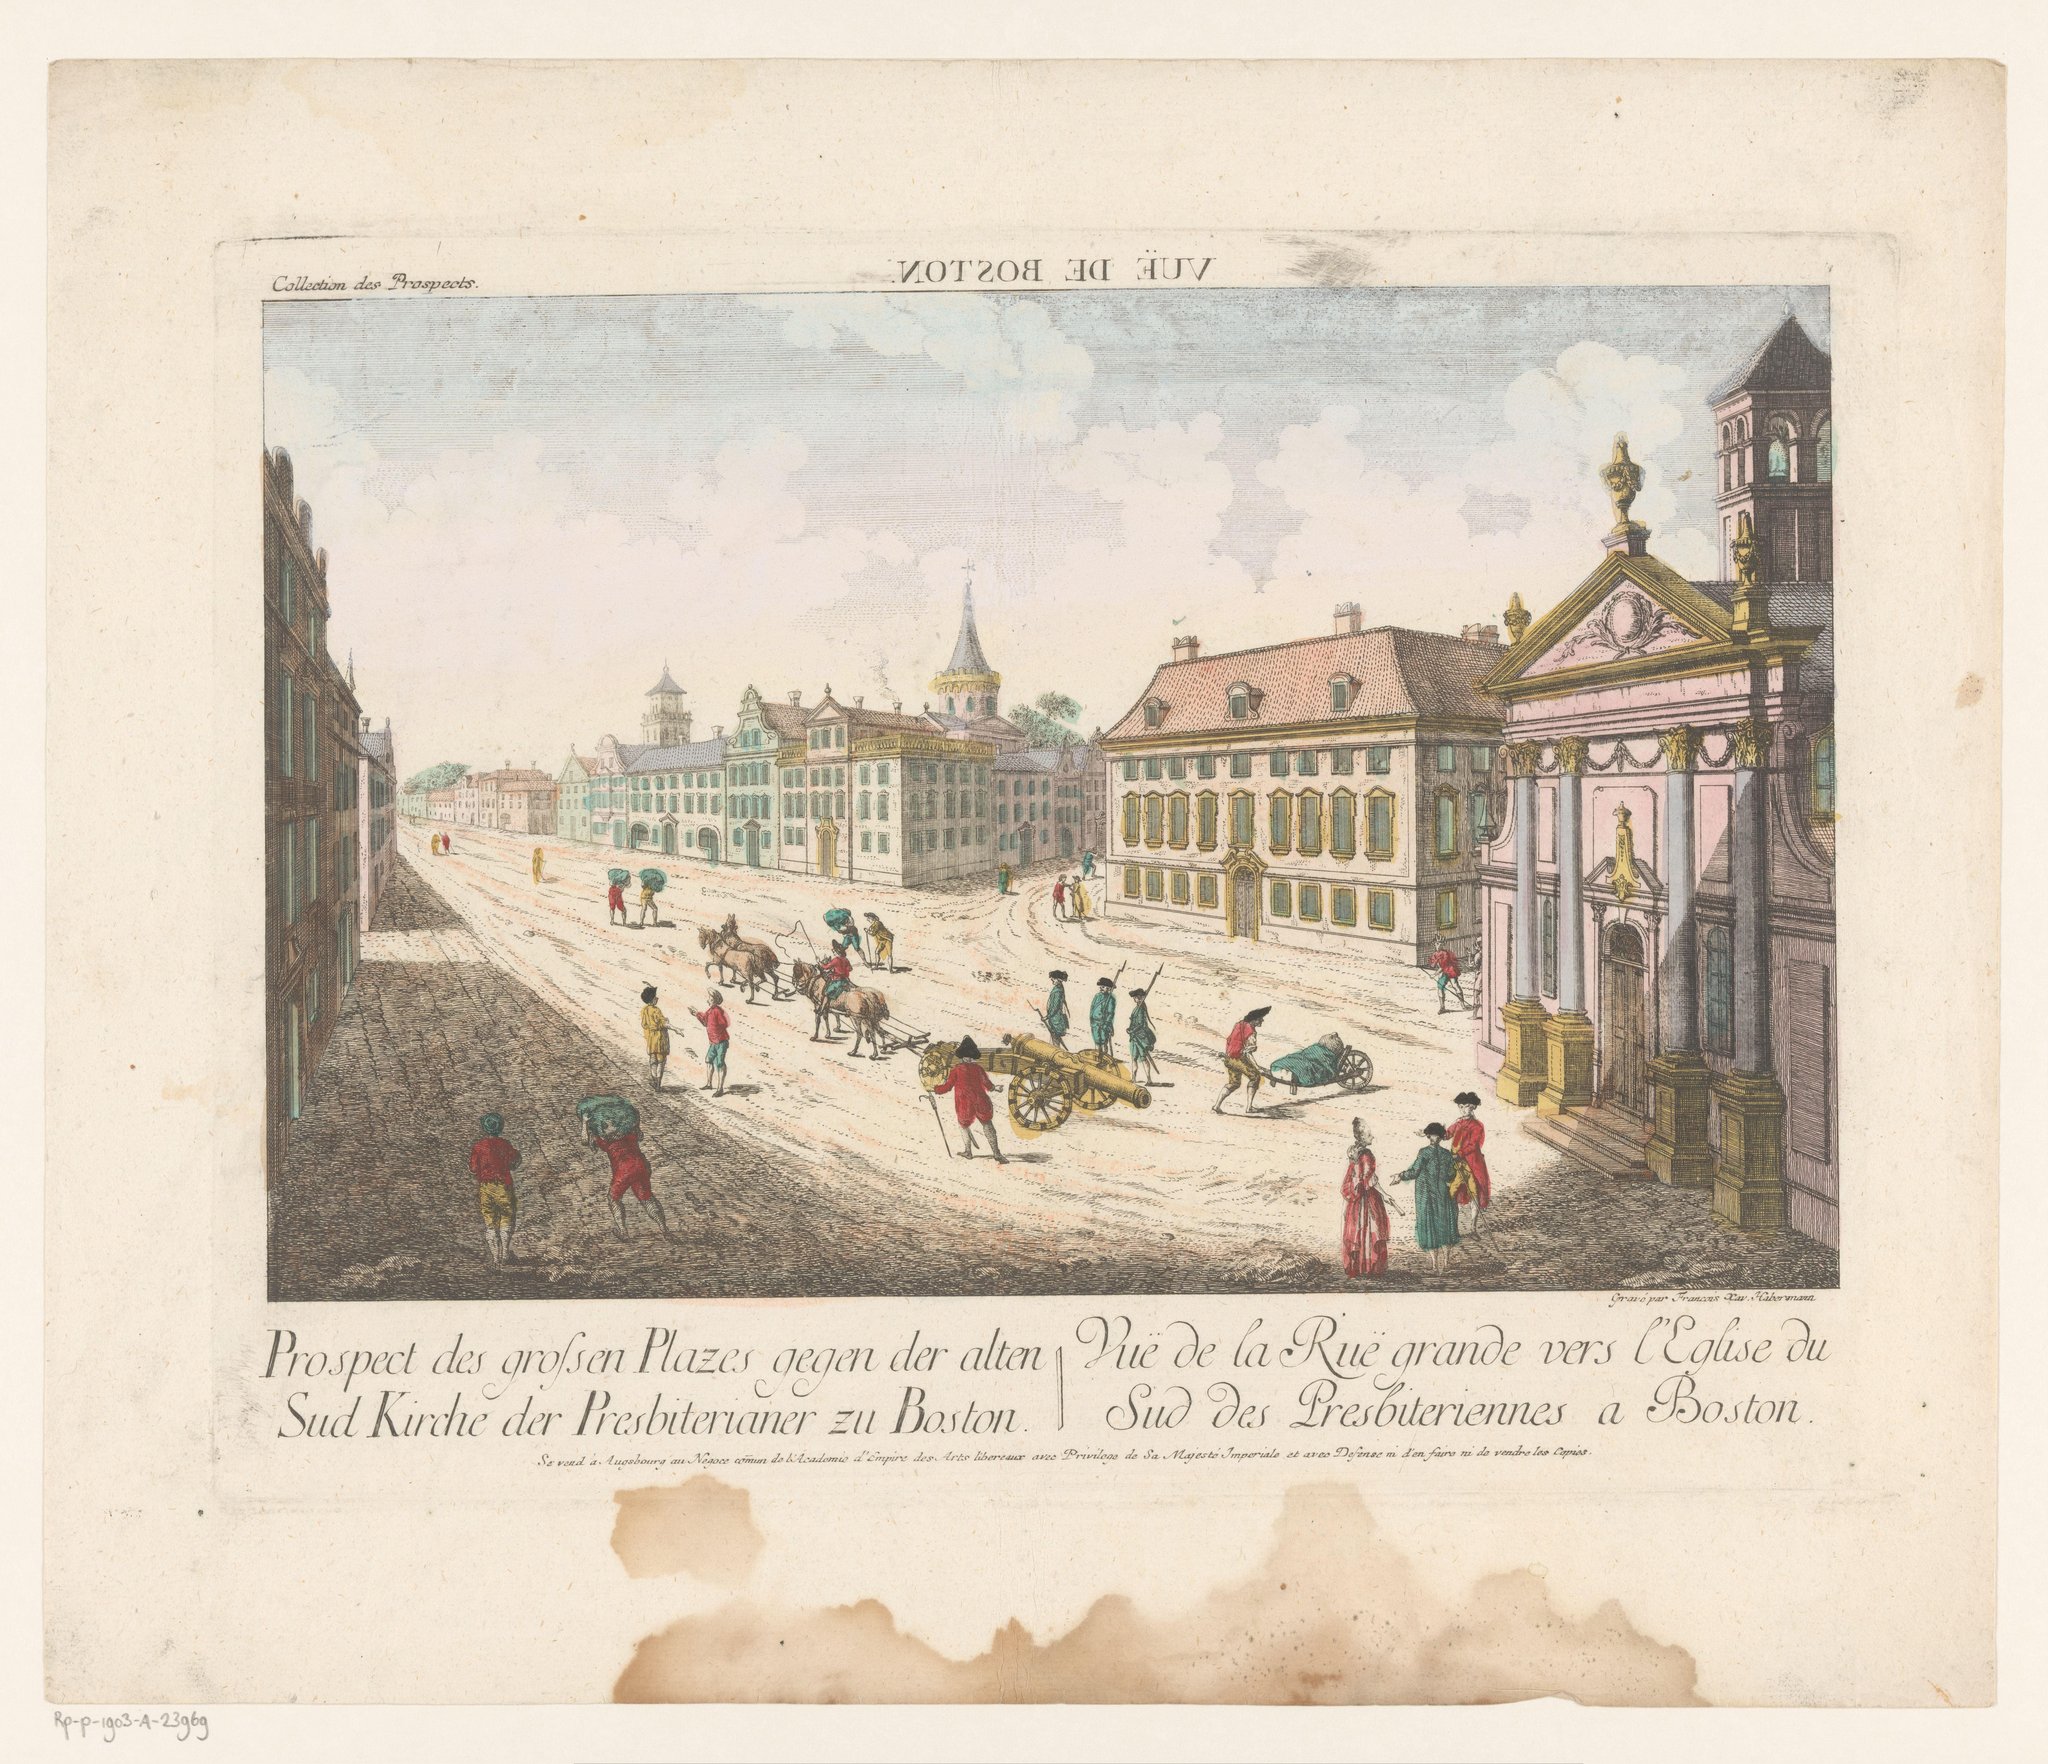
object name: print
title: Gezicht op de South Presbyterian Church te Boston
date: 1755-1779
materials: paper, watercolor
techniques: brush, etching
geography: augsburg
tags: church (exterior), street (+ city(-scape) with figures, staffage)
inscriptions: collector's mark: Lugt 2228